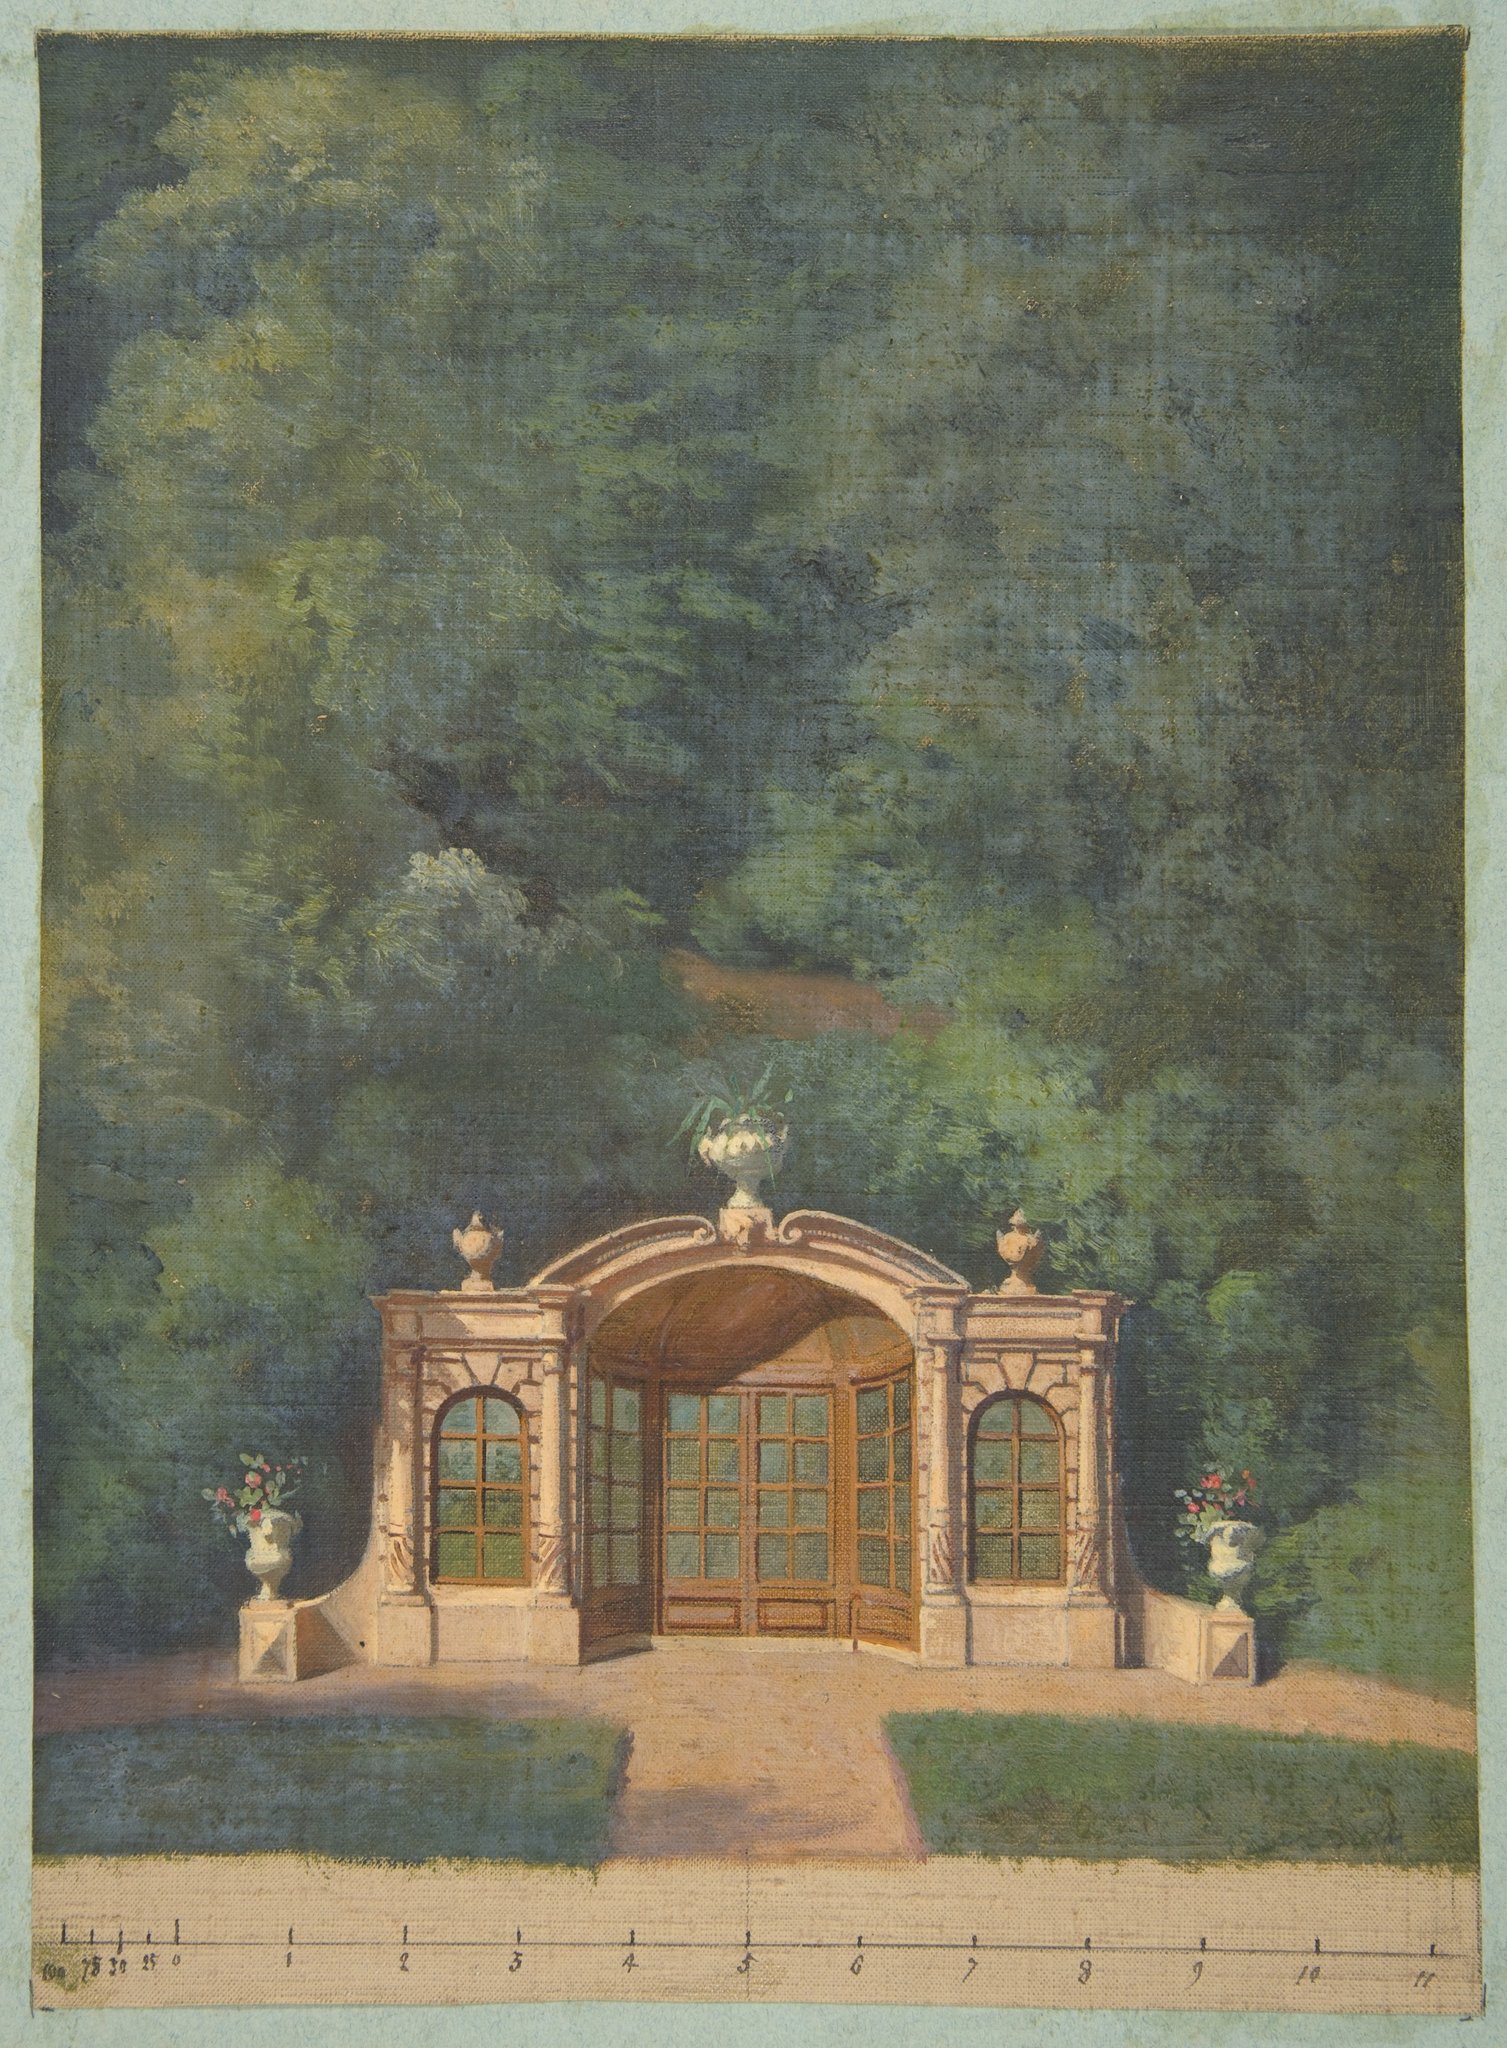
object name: drawing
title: A garden pavilion in a forested landscape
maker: jules-edmond-charles lachaise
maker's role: artist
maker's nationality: french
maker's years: 1897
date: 1830-1897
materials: canvas, oil, paper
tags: architecture,gardens,forests